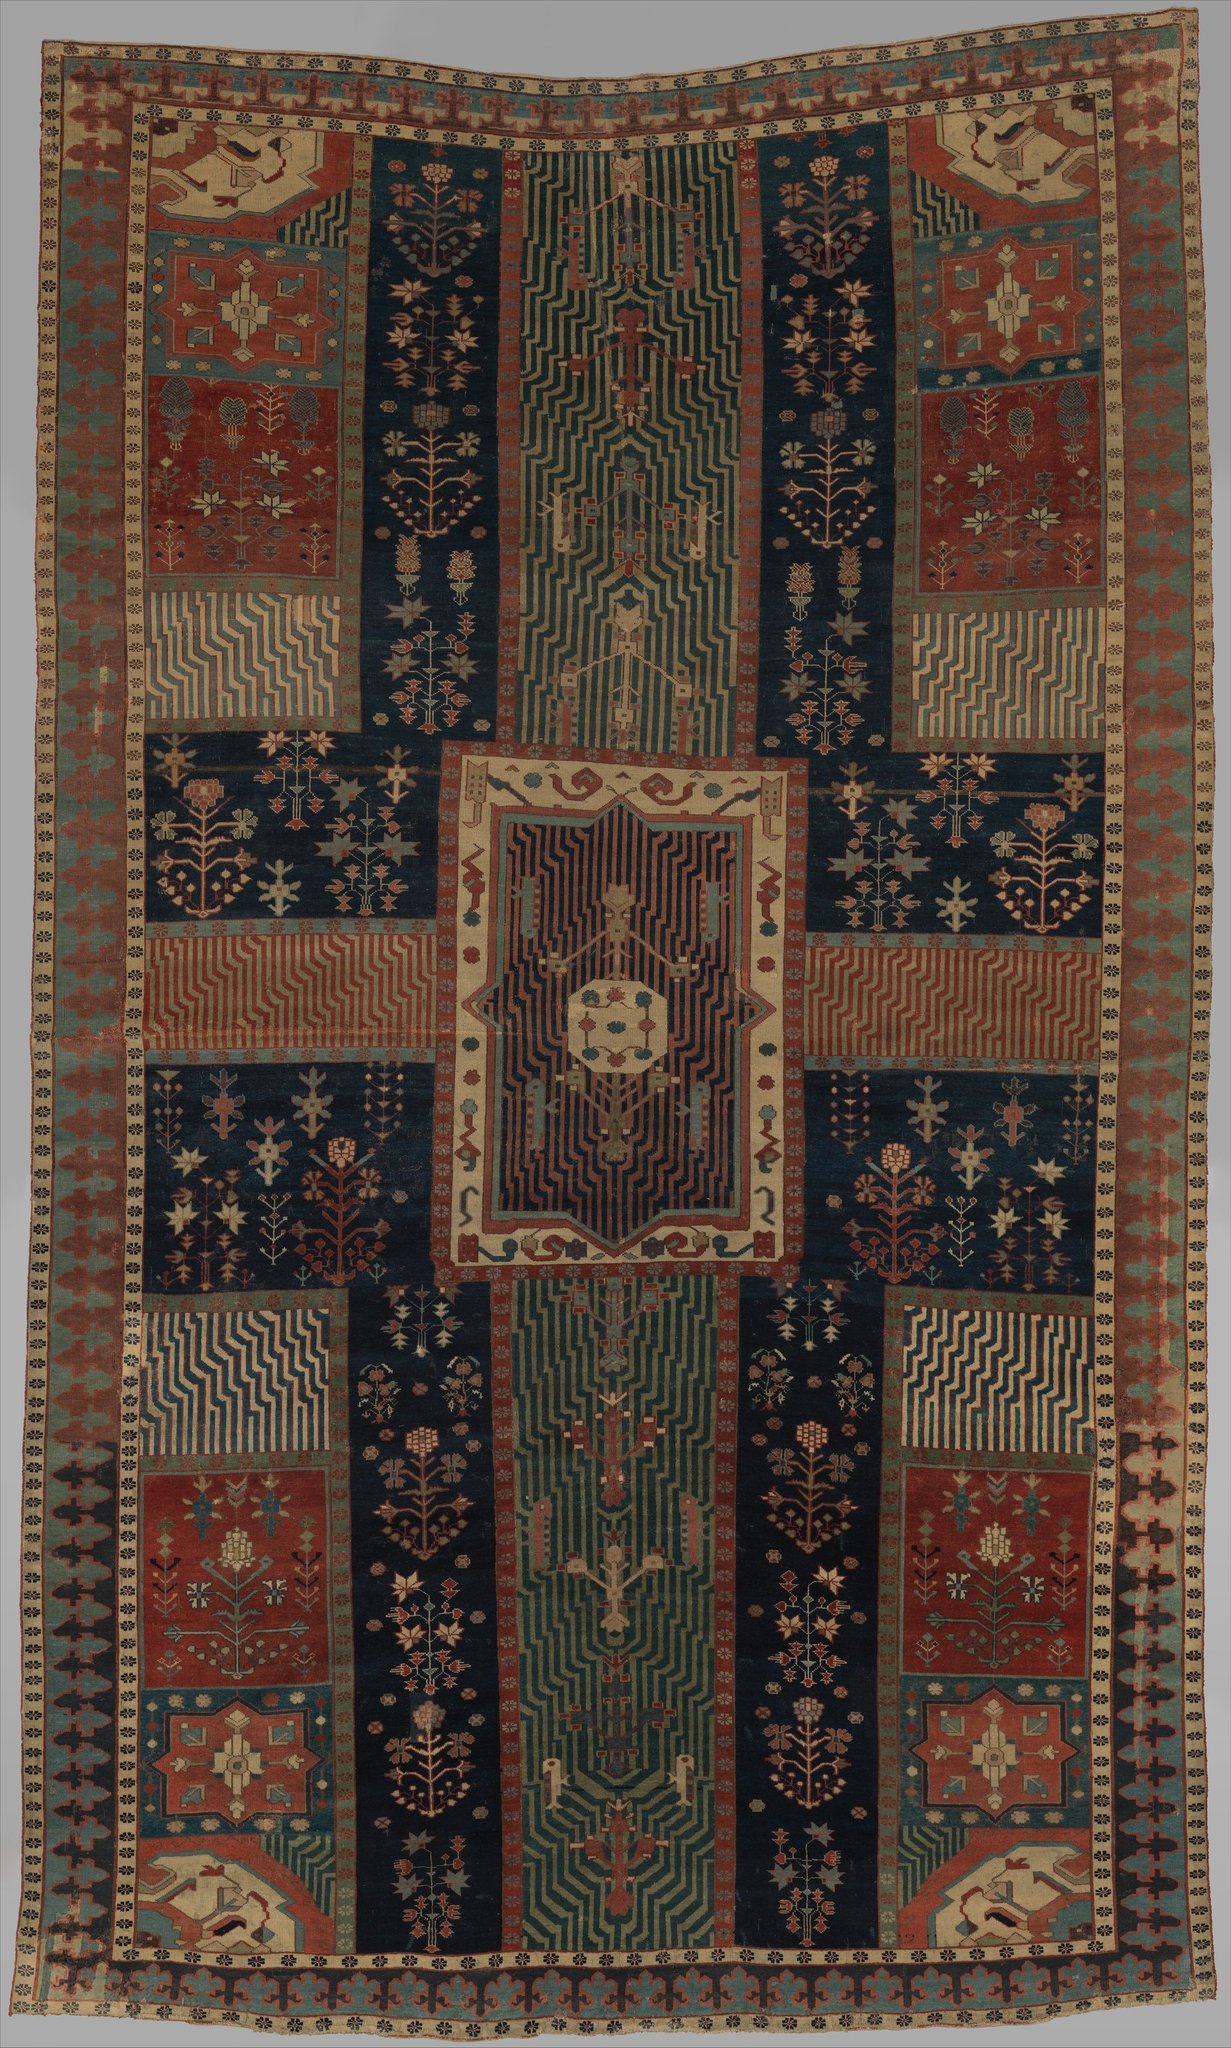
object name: carpet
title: Garden Carpet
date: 1751-1800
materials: cotton, wool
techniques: pile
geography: iran